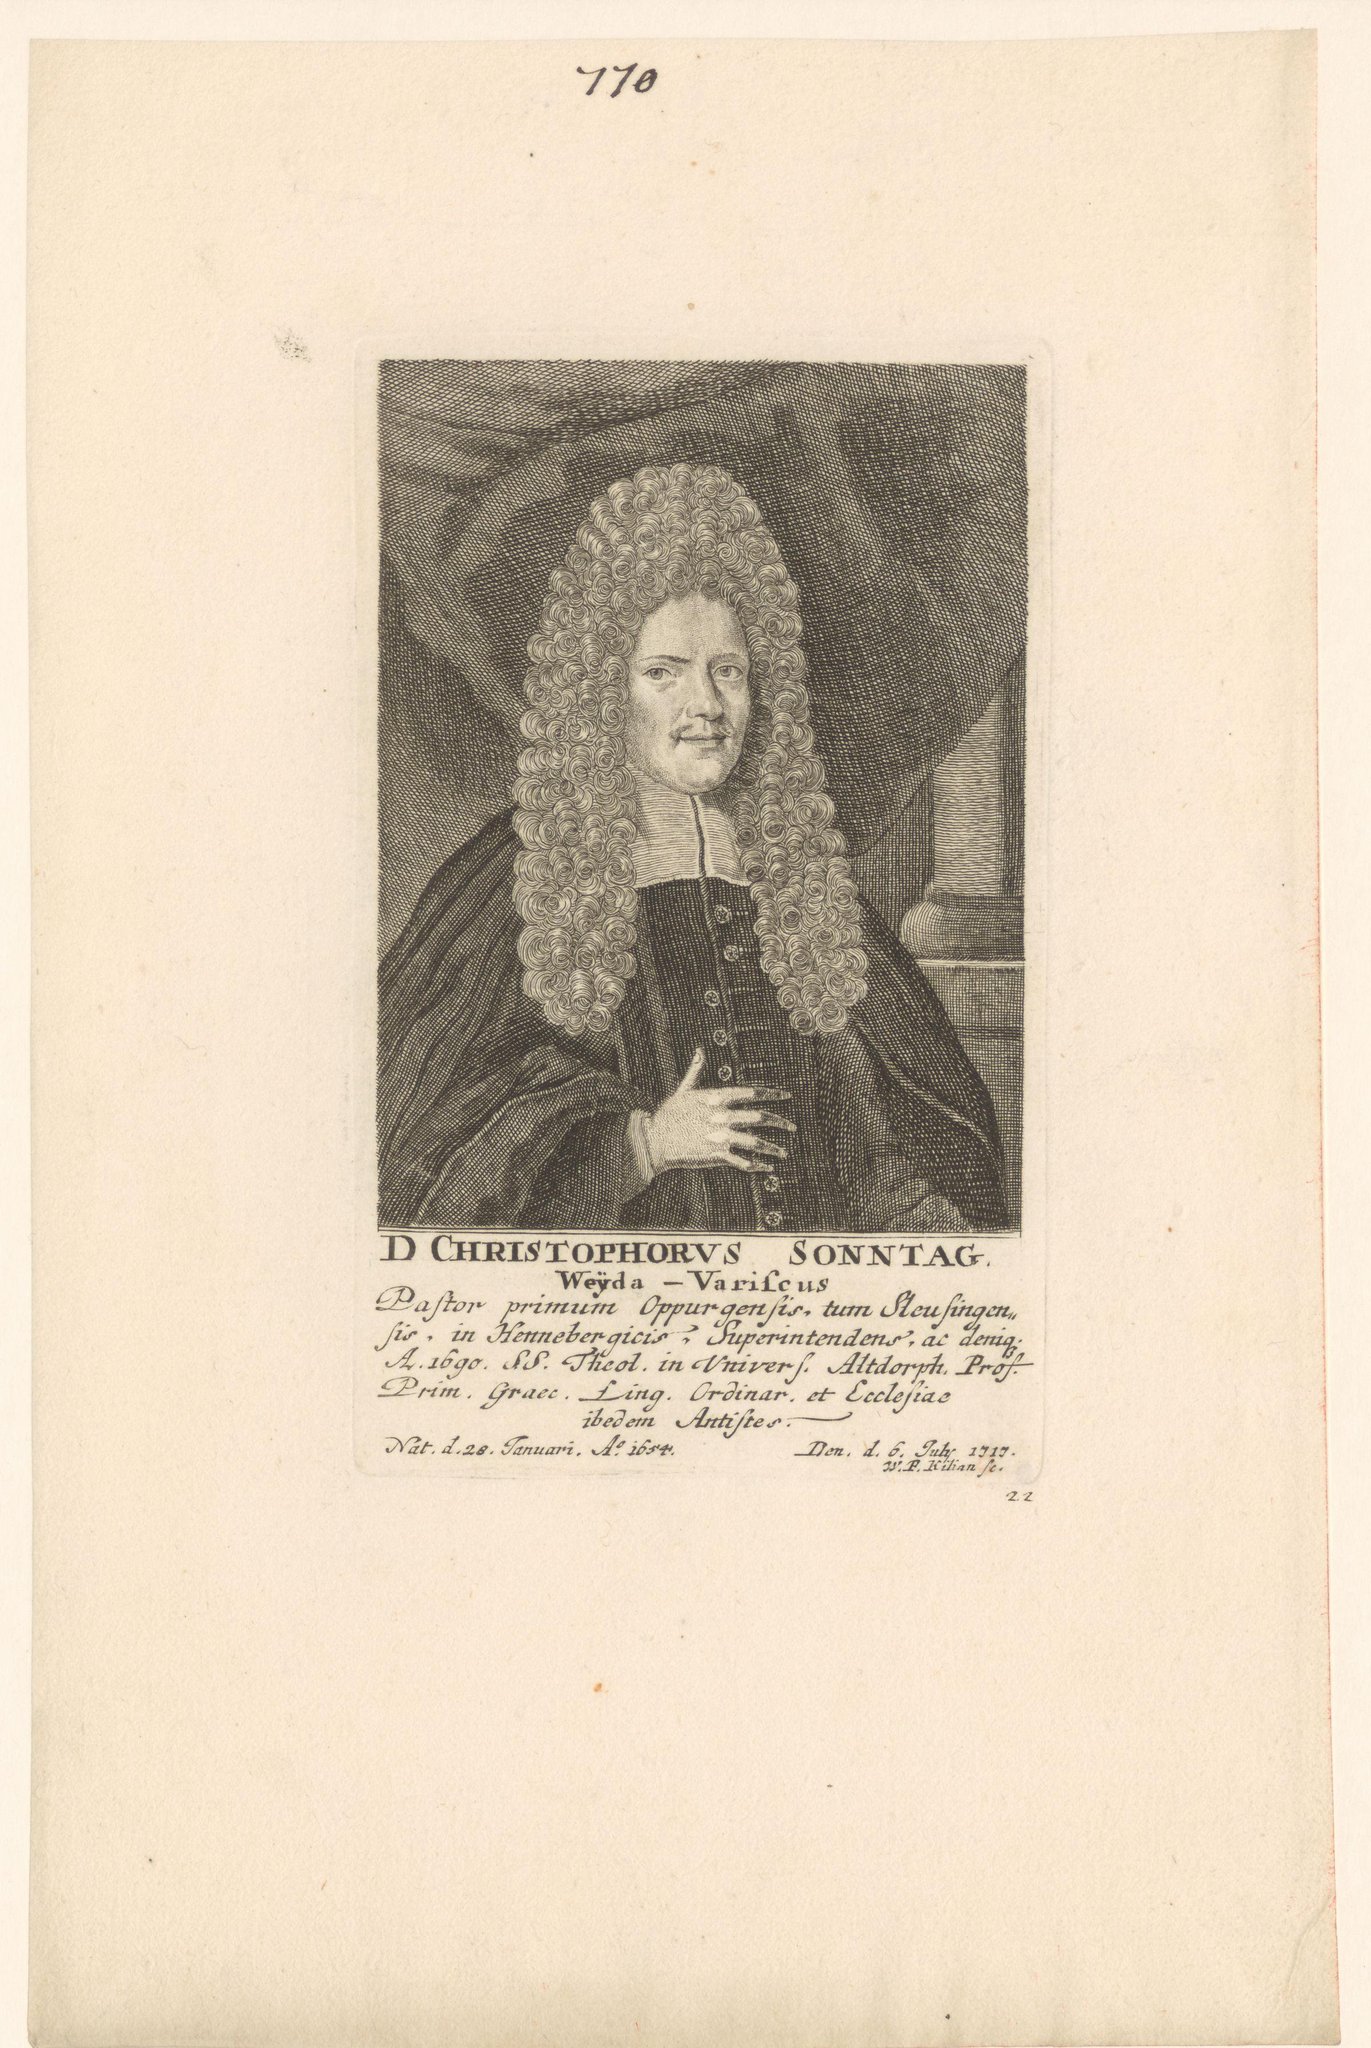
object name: print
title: Portret van Christoph Sonntag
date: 1717-1722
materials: paper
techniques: engraving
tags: christoph sonntag, theologian, further education (+ portrait of teacher, professor), historical persons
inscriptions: number: ‘22’, collector's mark: Lugt 2228